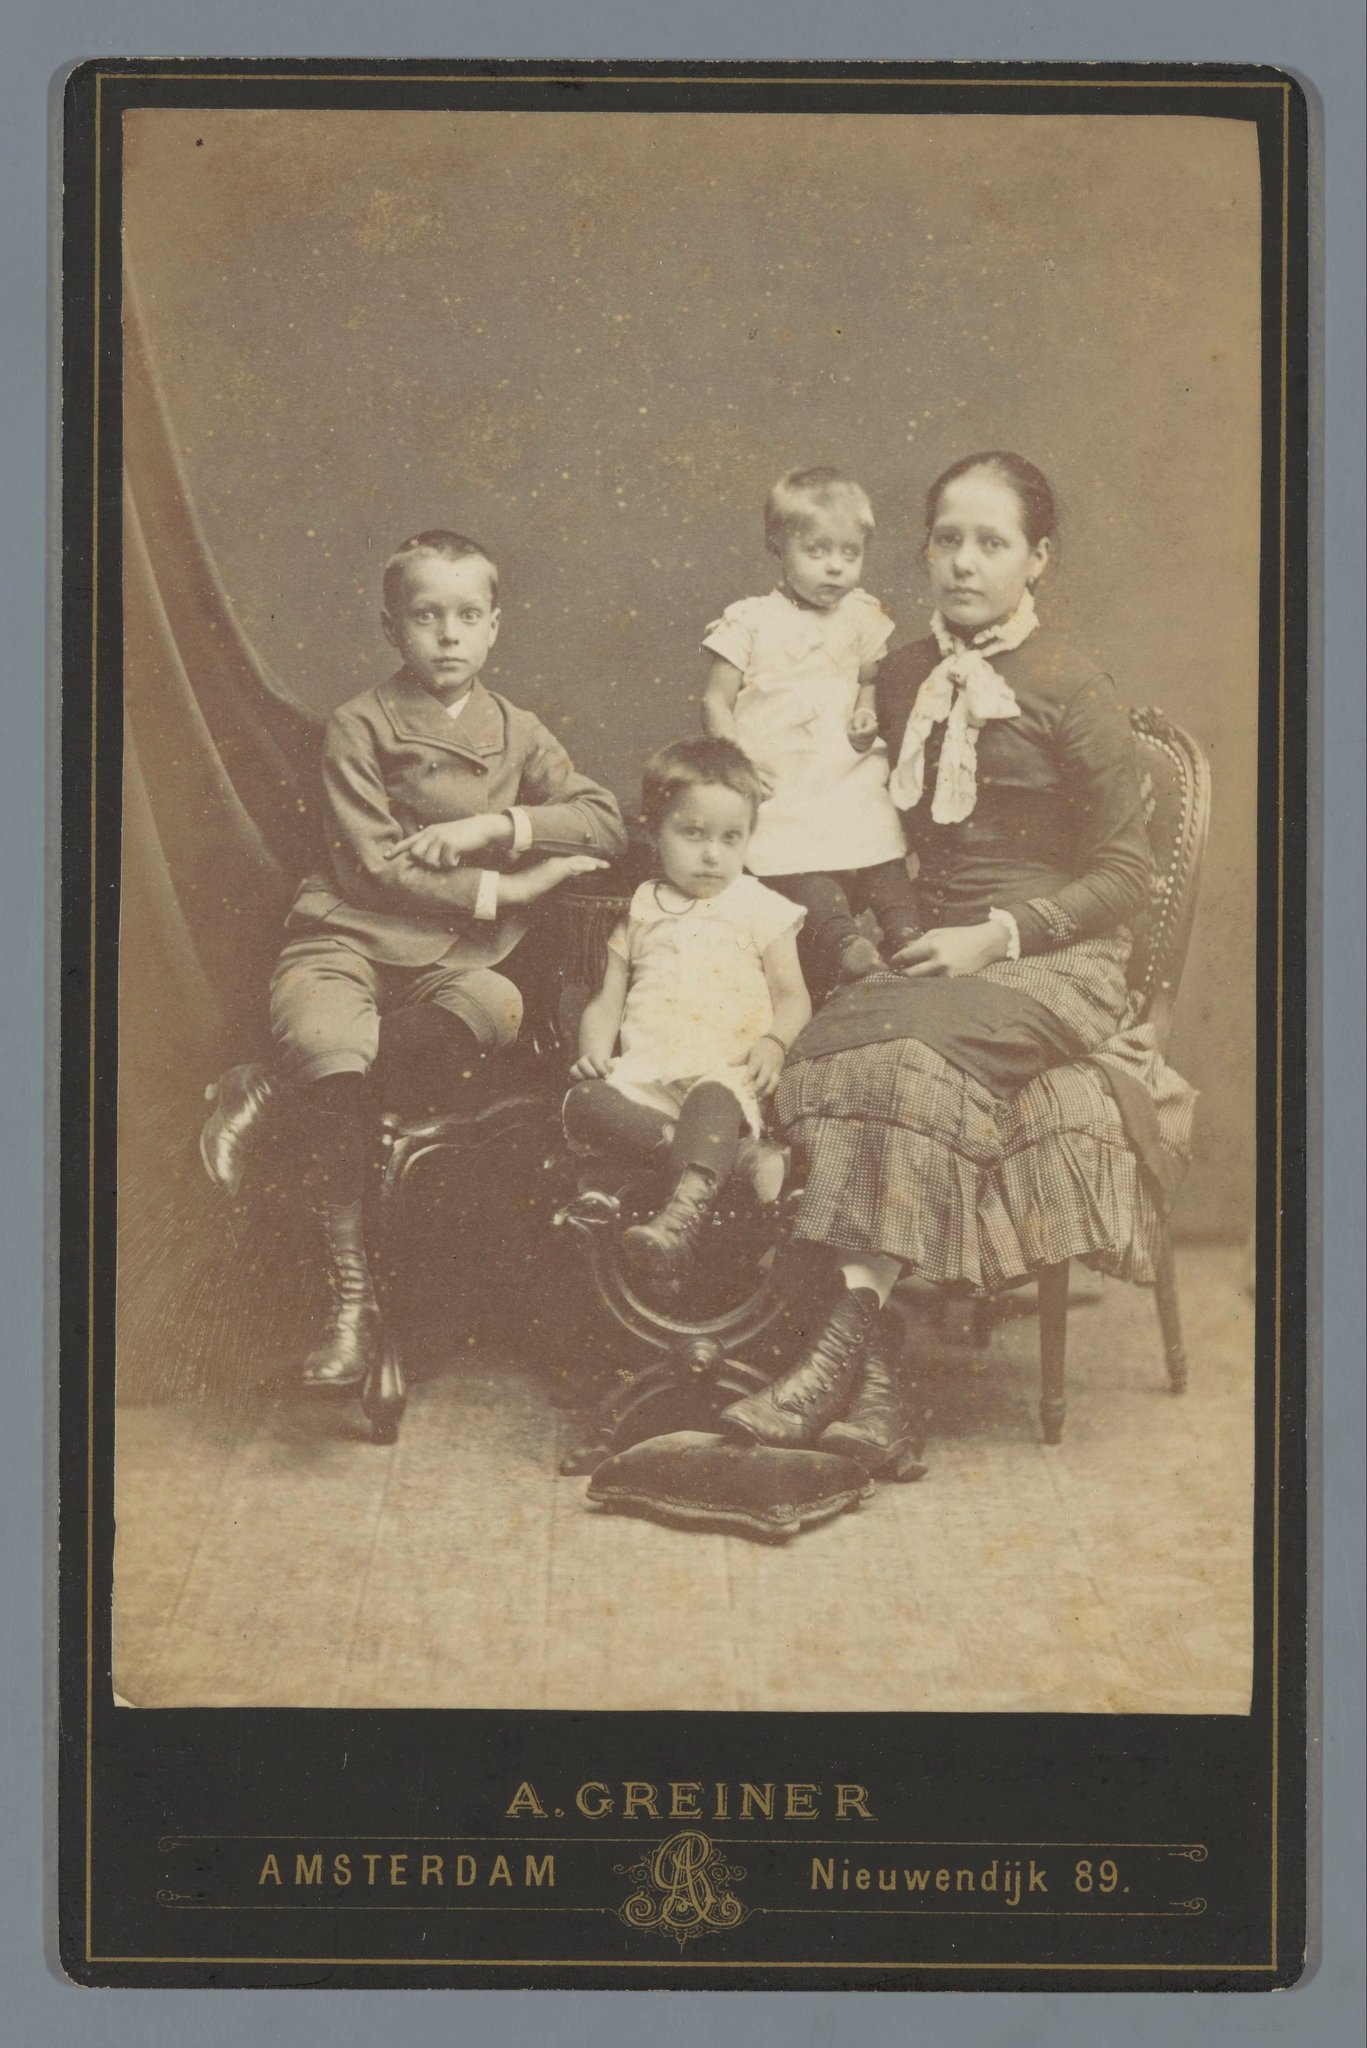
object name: cabinet photograph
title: Portret van een onbekende vrouw met drie kinderen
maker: albert greiner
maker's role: fotograaf, fotostudio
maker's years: 1833-1890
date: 1861-1890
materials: cardboard, photographic support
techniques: albumen print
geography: amsterdam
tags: mother and child(ren), woman and child(ren) (family group)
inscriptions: name: ‘Albert Greiner Kon.Ned. Hof-Photograaf Amsterdam Nieuwendijk 89. (...)’